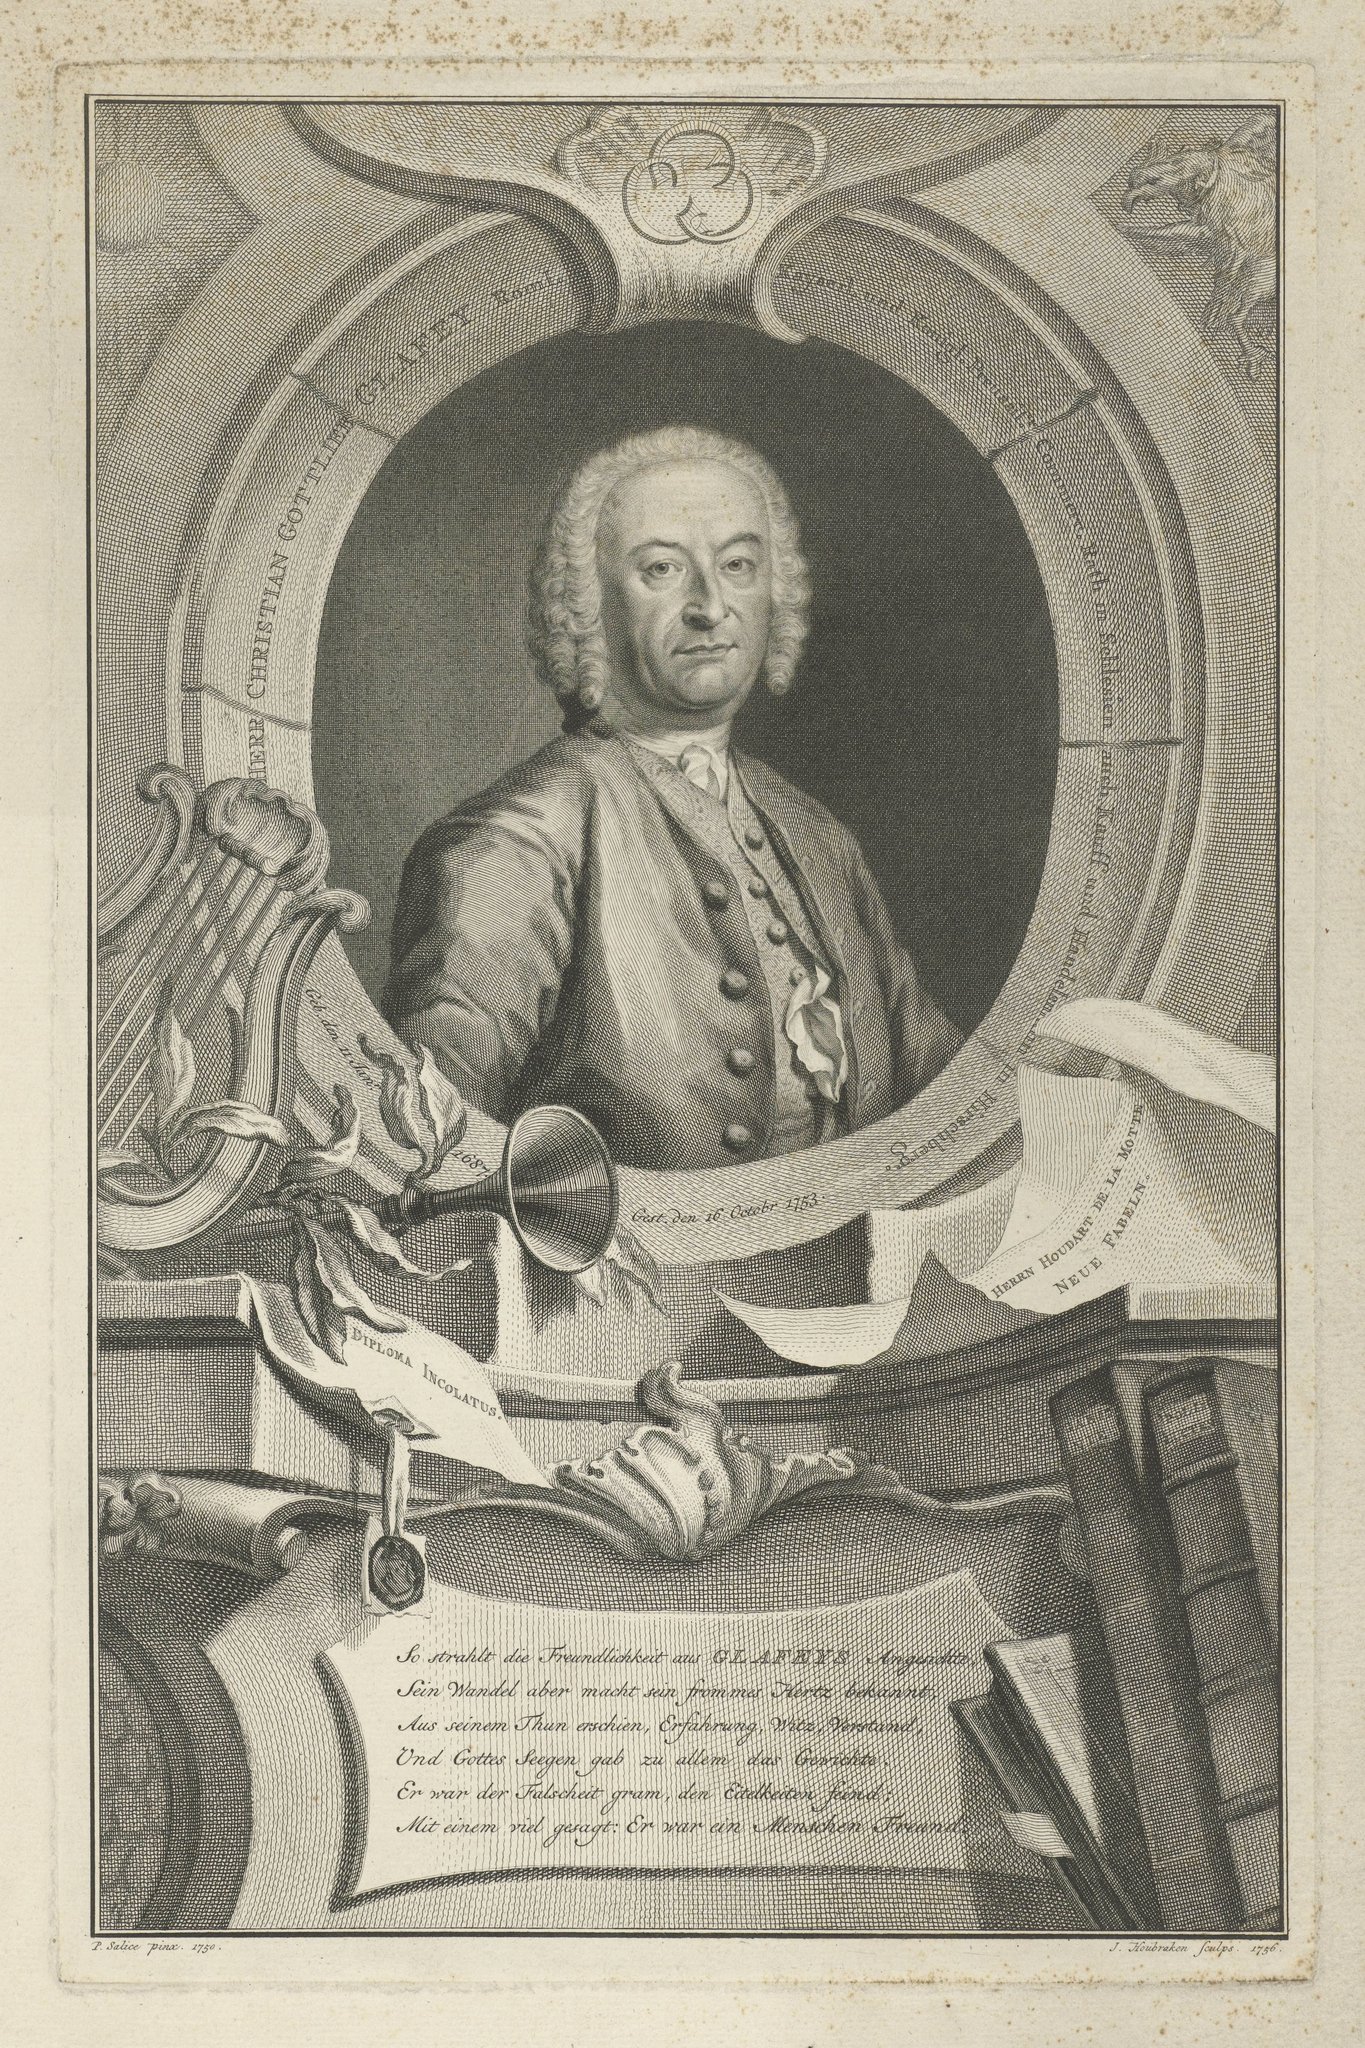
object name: print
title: Christian Gottlieb Glafey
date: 1756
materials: paper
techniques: engraving, etching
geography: amsterdam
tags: dichter, schrijver, christian gottlieb glafey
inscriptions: collector's mark: Lugt 2228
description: Christian Gottlieb Glafey, ten halven lijve naar rechts, in een architectonisch cartouche met randschrift in het Duits. Onder het portret een richel, waaronder een plaquette met een zesregelig vers in het Duits. Op het cartouche papieren en emblemen van de poëzie, zoals de lier en een loftrompet.